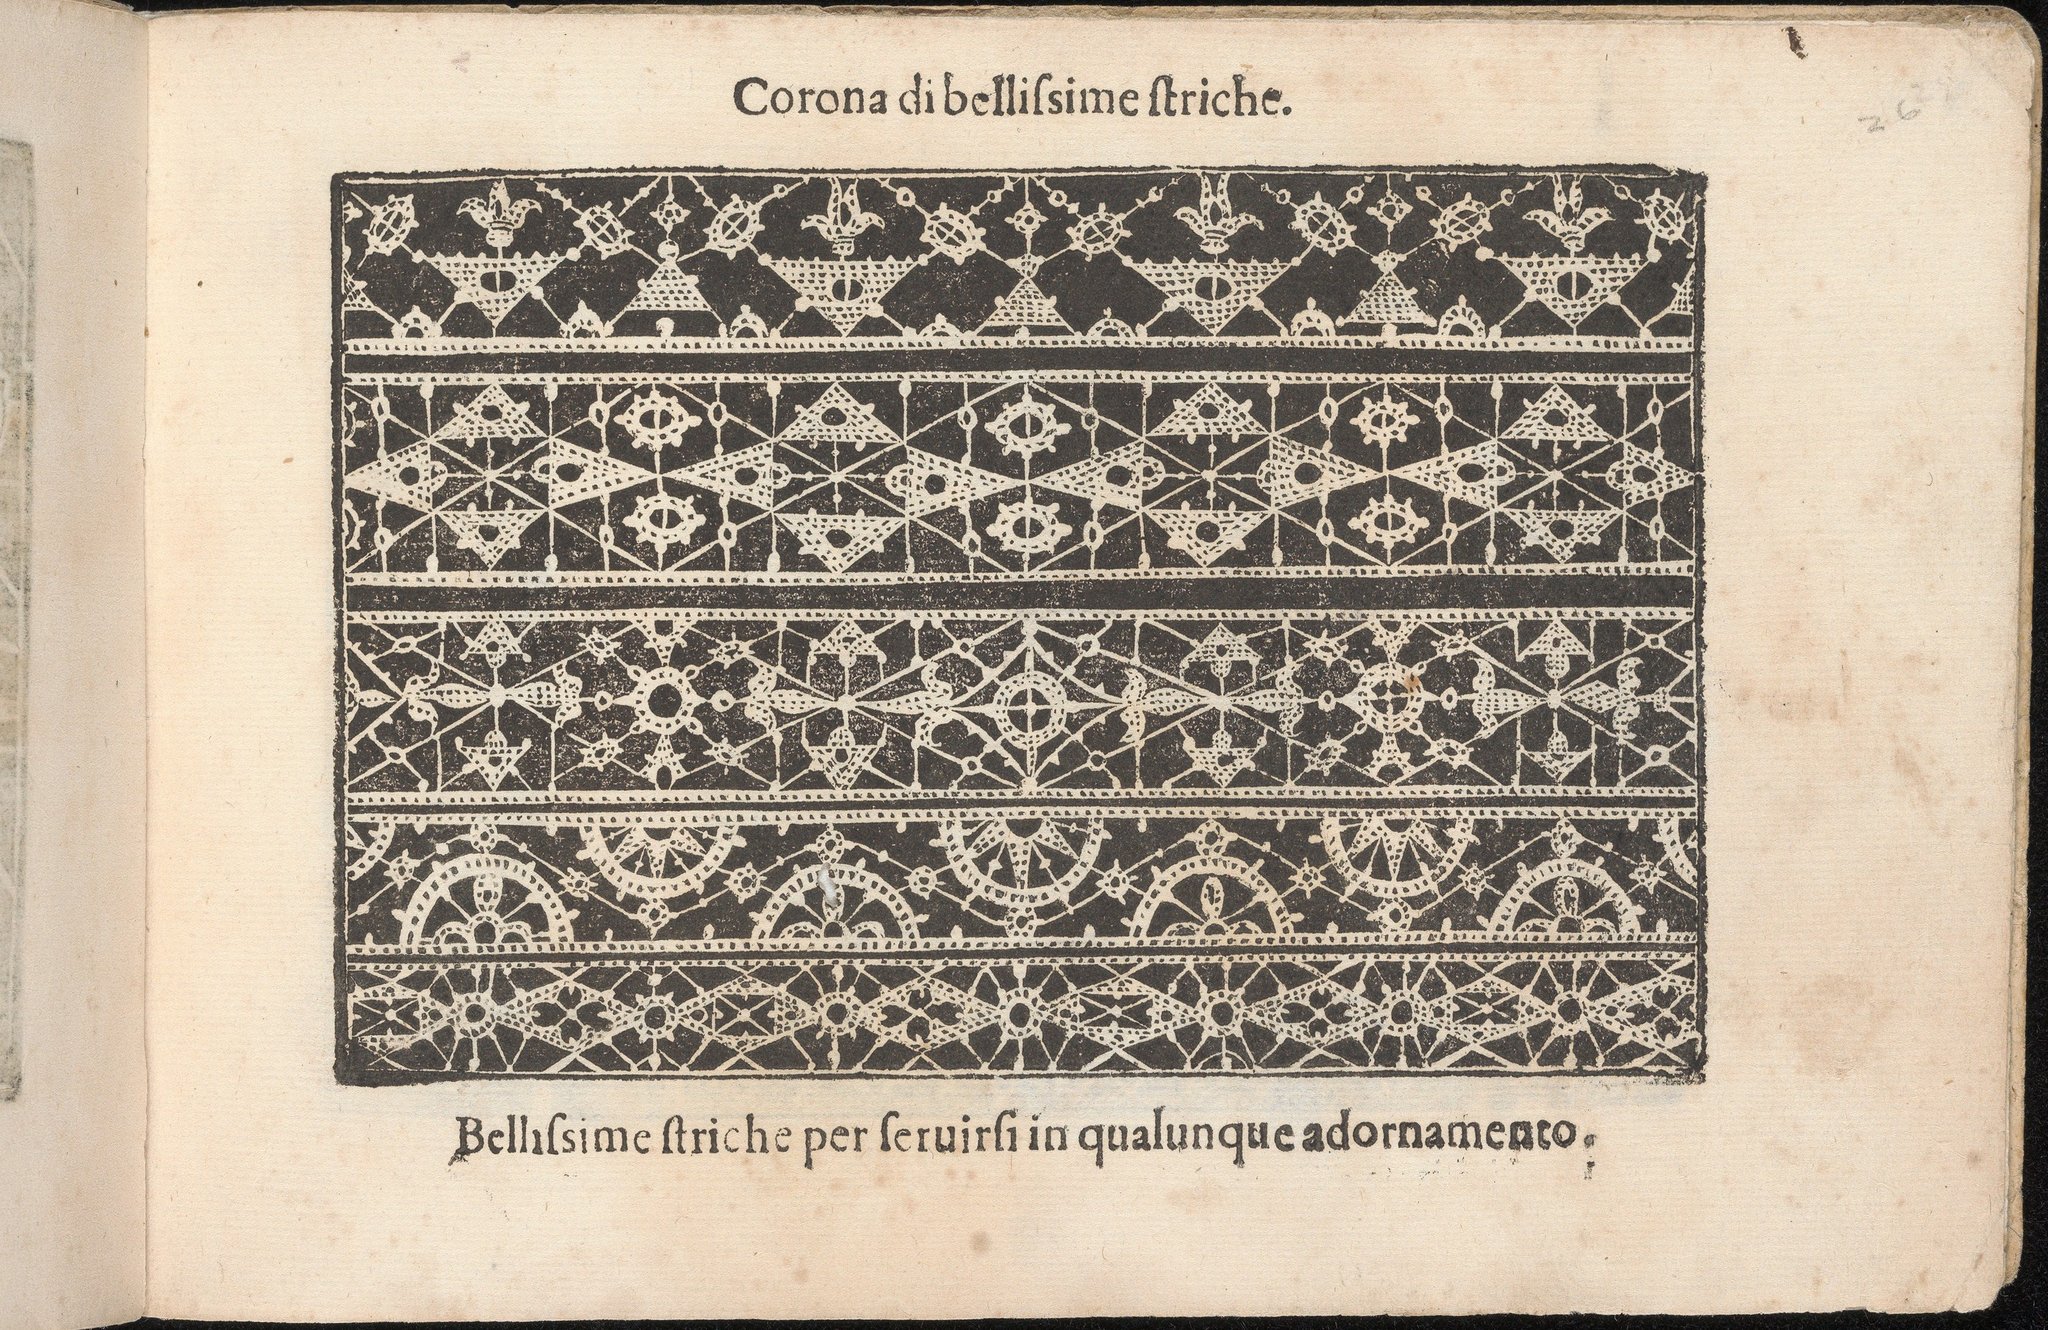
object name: book print ornament architecture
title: Corona delle Nobile et Virtuose Donne, Libro Terzo, page 26 (recto)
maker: cesare vecellio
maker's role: designer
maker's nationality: italian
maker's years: 1521-1601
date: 1620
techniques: woodcut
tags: ornament